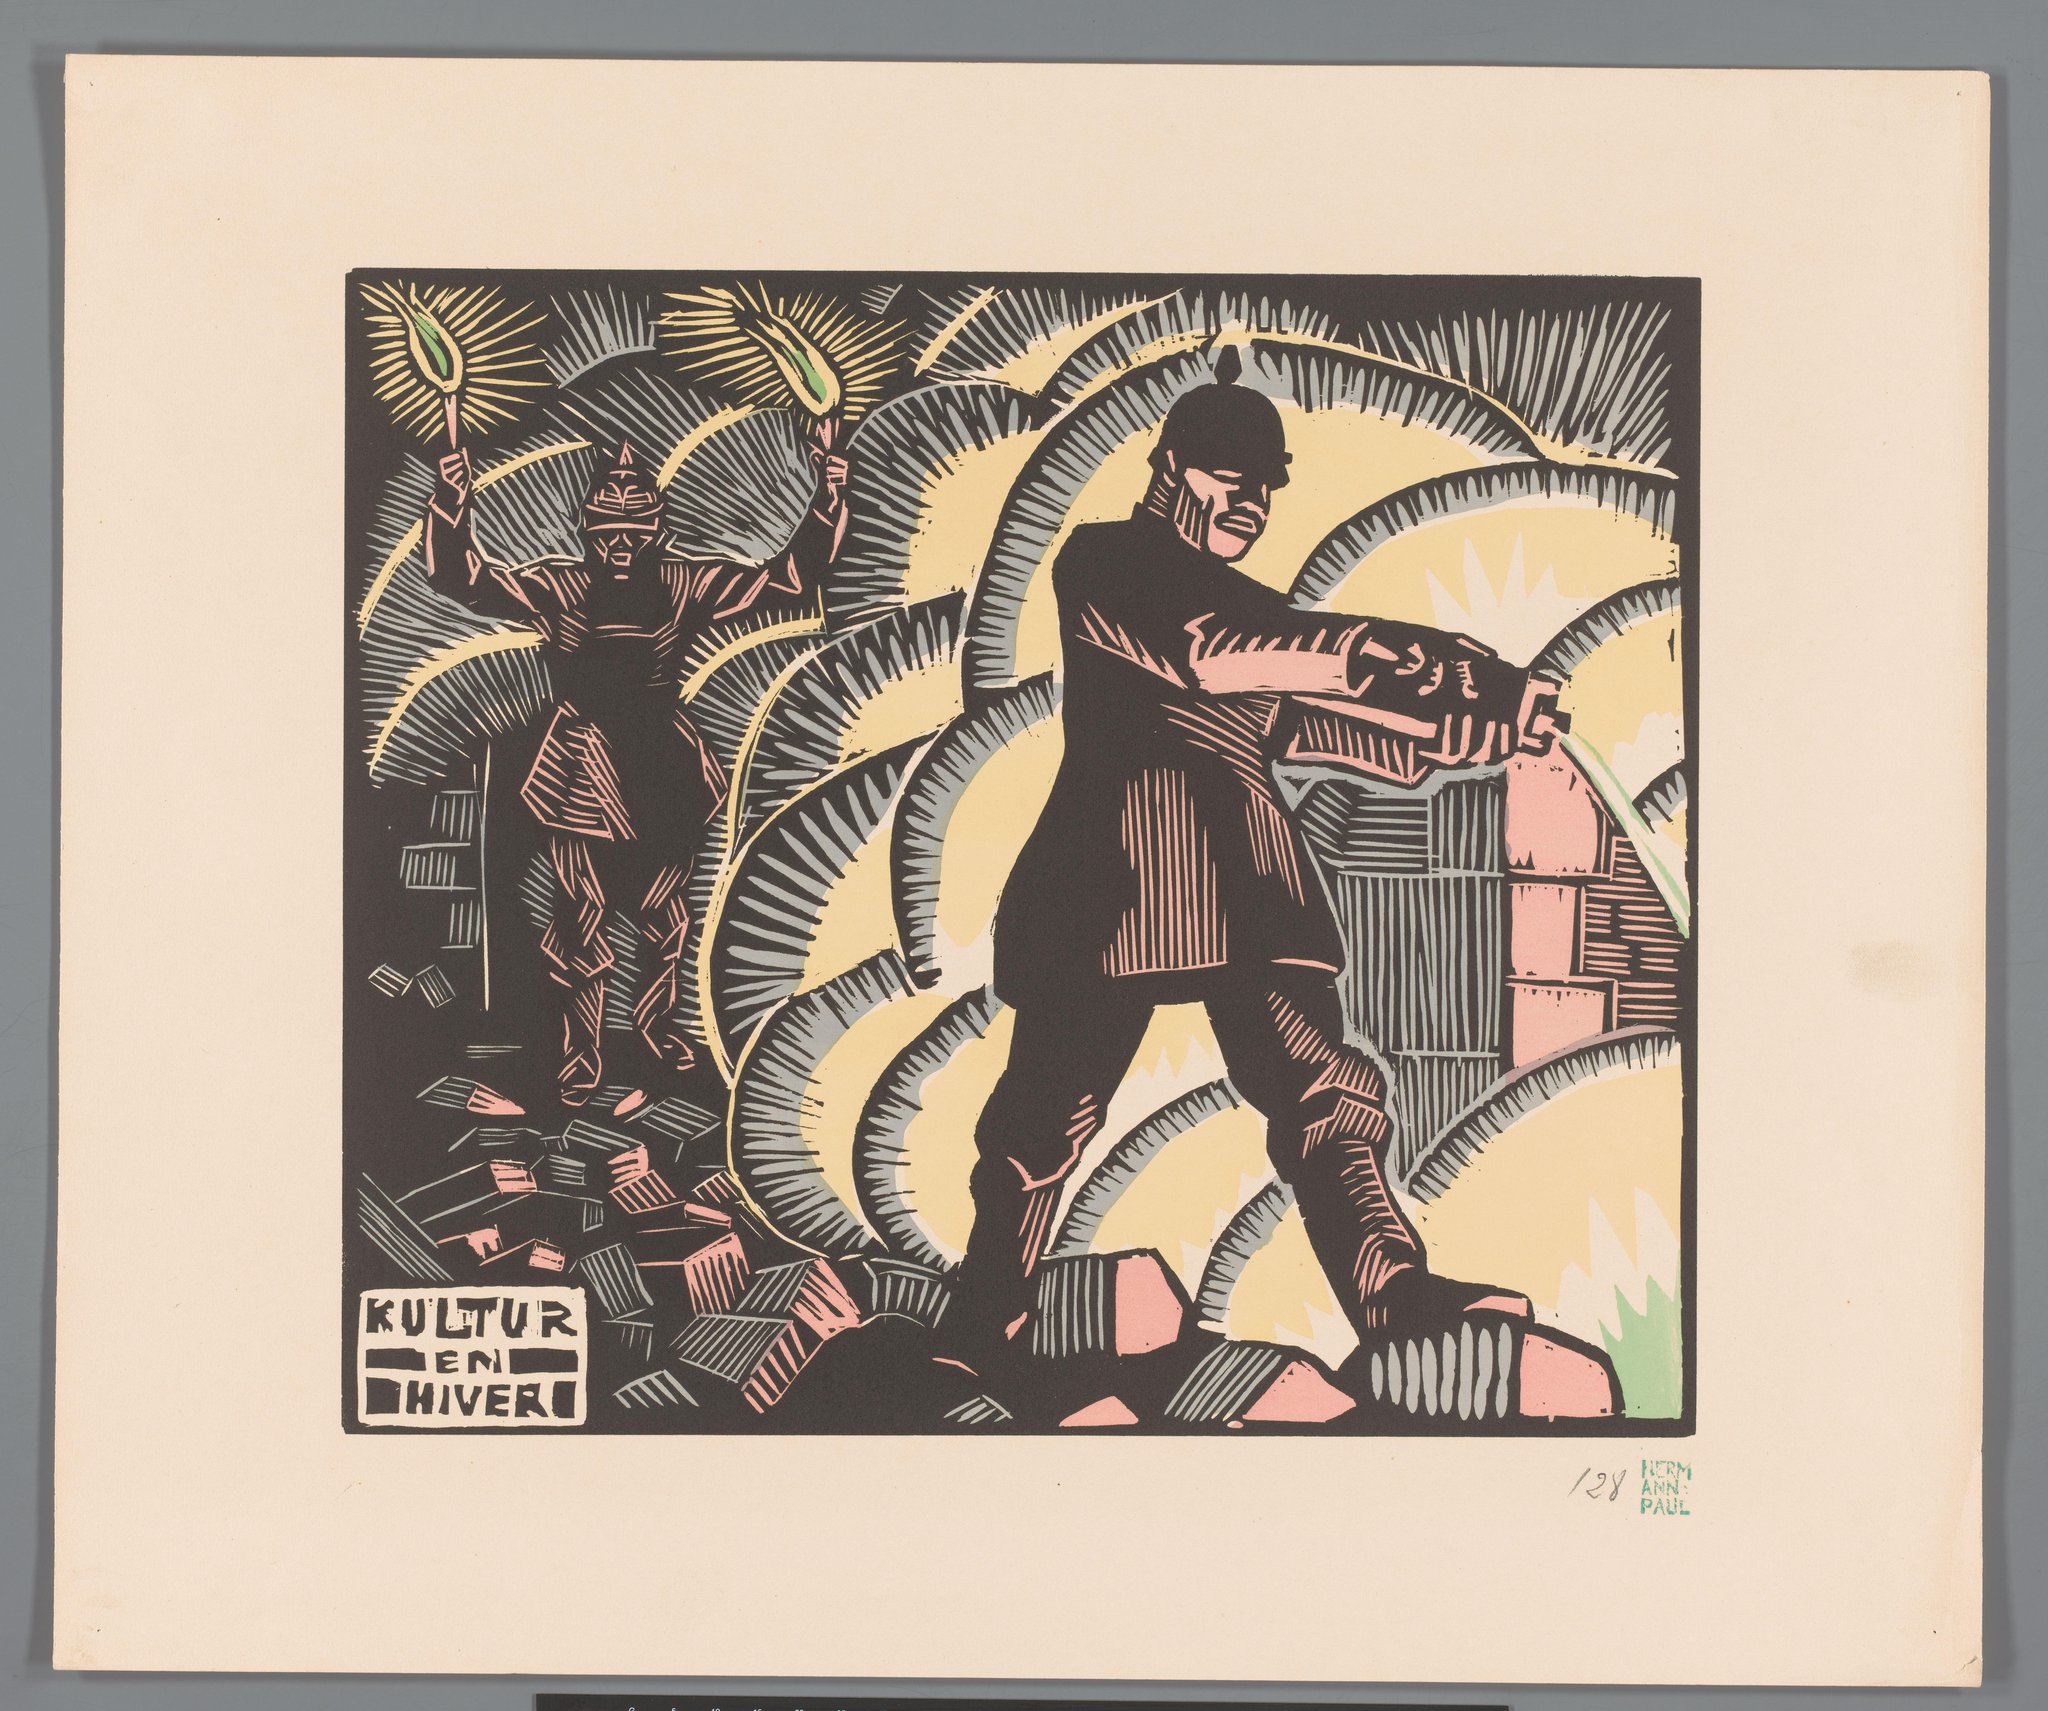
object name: print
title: Soldaten steken gebouwen in brand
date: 1915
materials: paper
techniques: woodcut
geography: paris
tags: setting on fire (of conquered city)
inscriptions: collector's mark: Lugt 2233, workshop stamp: ‘Hermann: Paul’